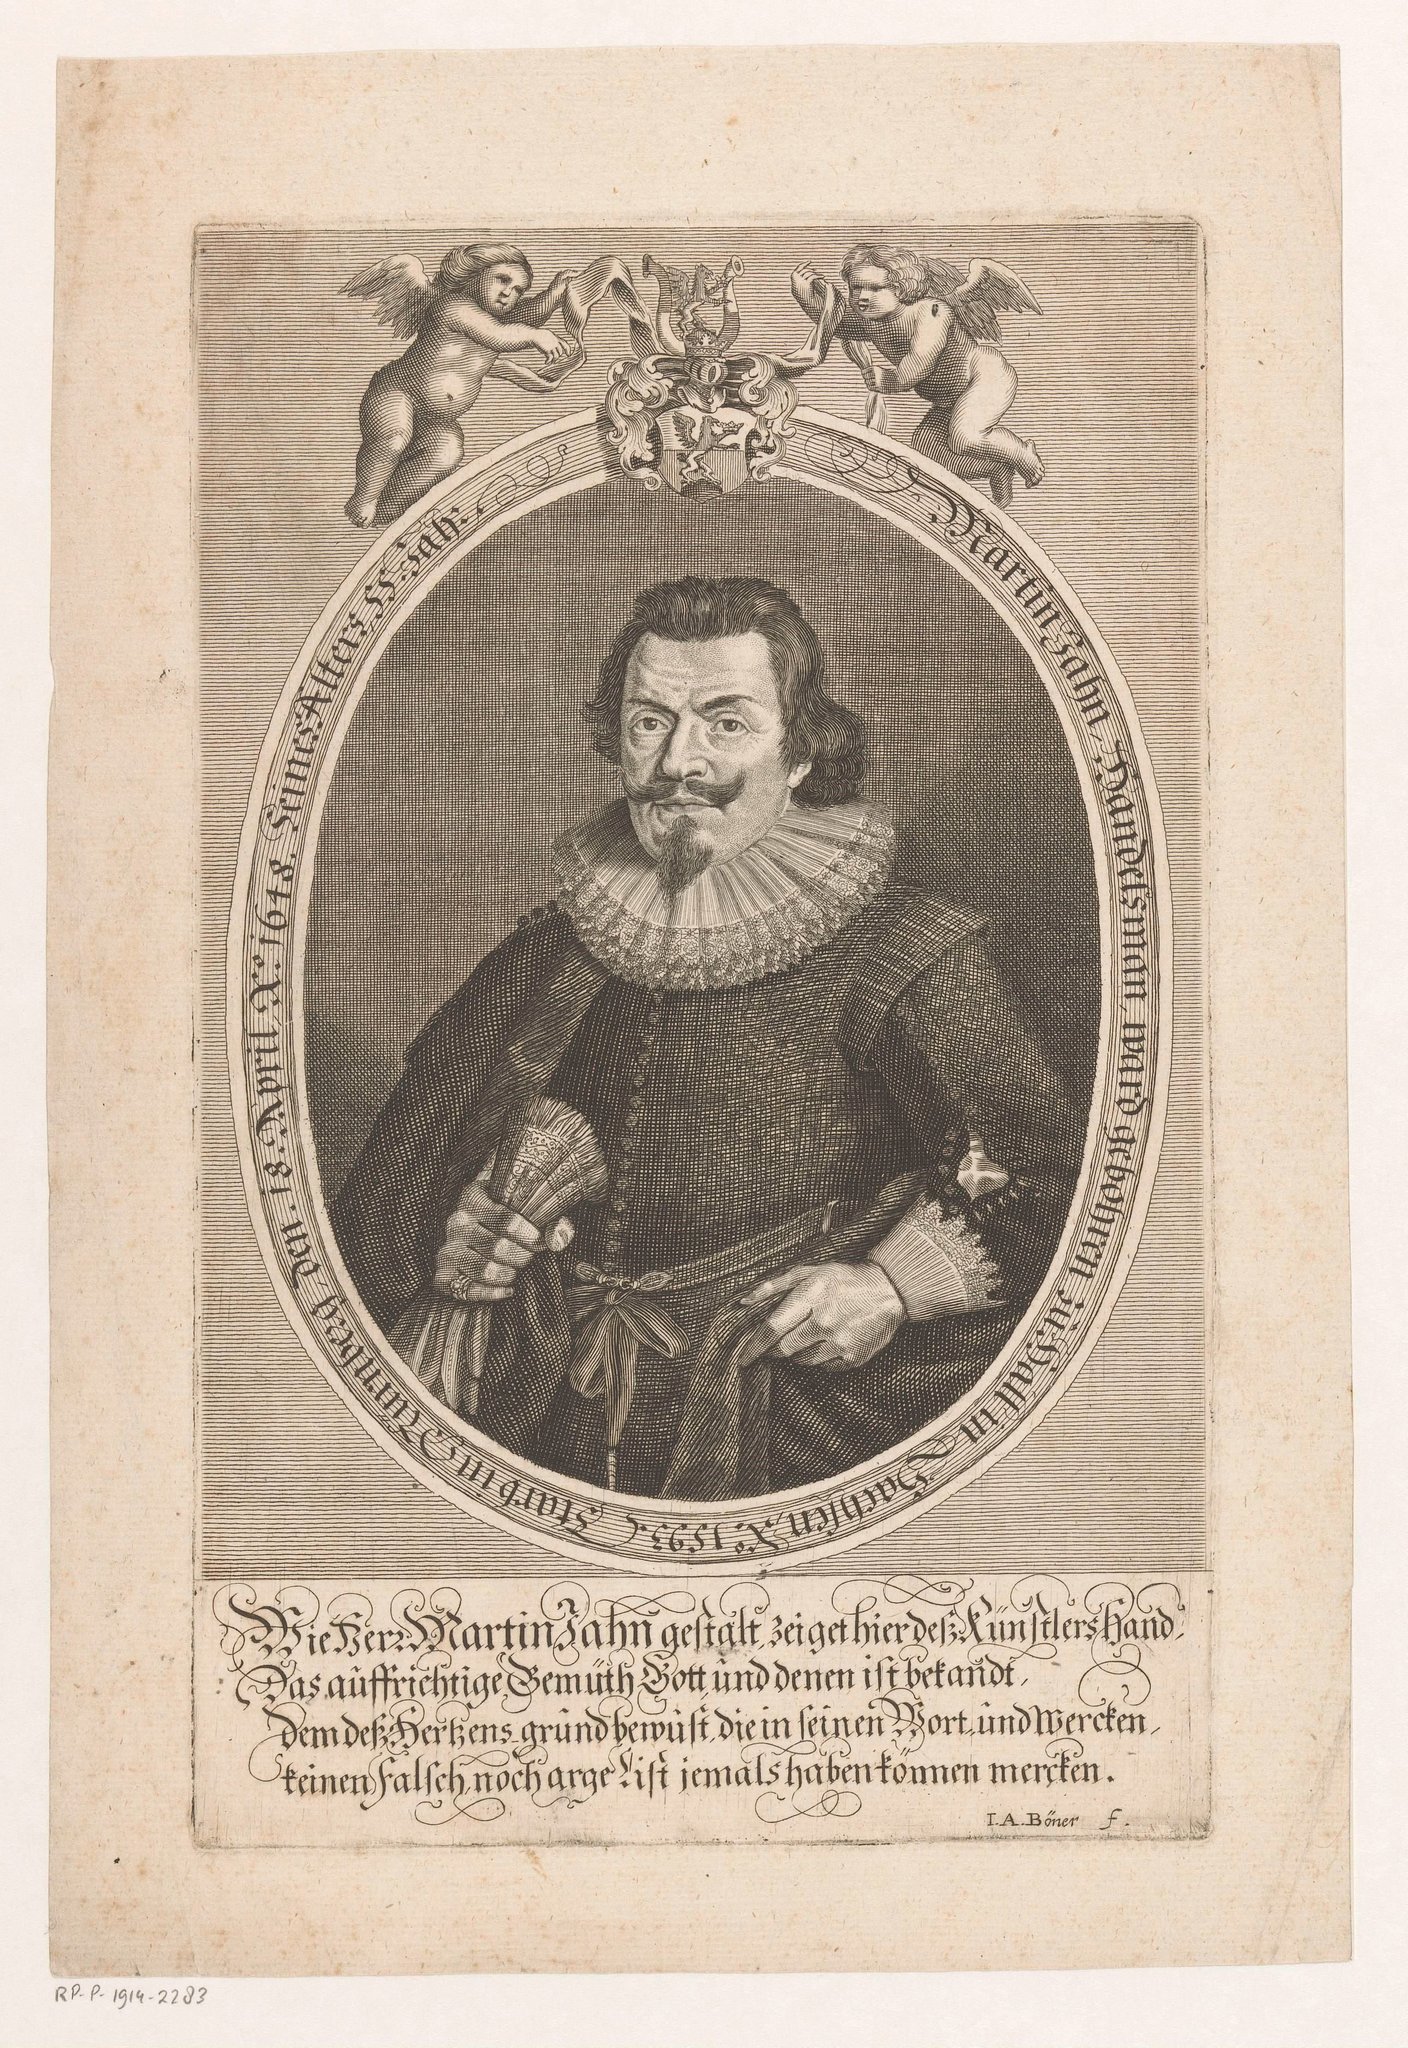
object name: print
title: Portret van Martin Zahn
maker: johann alexander böner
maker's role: draughtsman, print maker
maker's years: 1647-1720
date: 1657-1720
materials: paper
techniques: engraving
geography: nuremberg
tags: gloves, mittens, etc., historical persons, cupids: 'amores', 'amoretti', 'putti', armorial bearing, heraldry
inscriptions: collector's mark: Lugt 2228